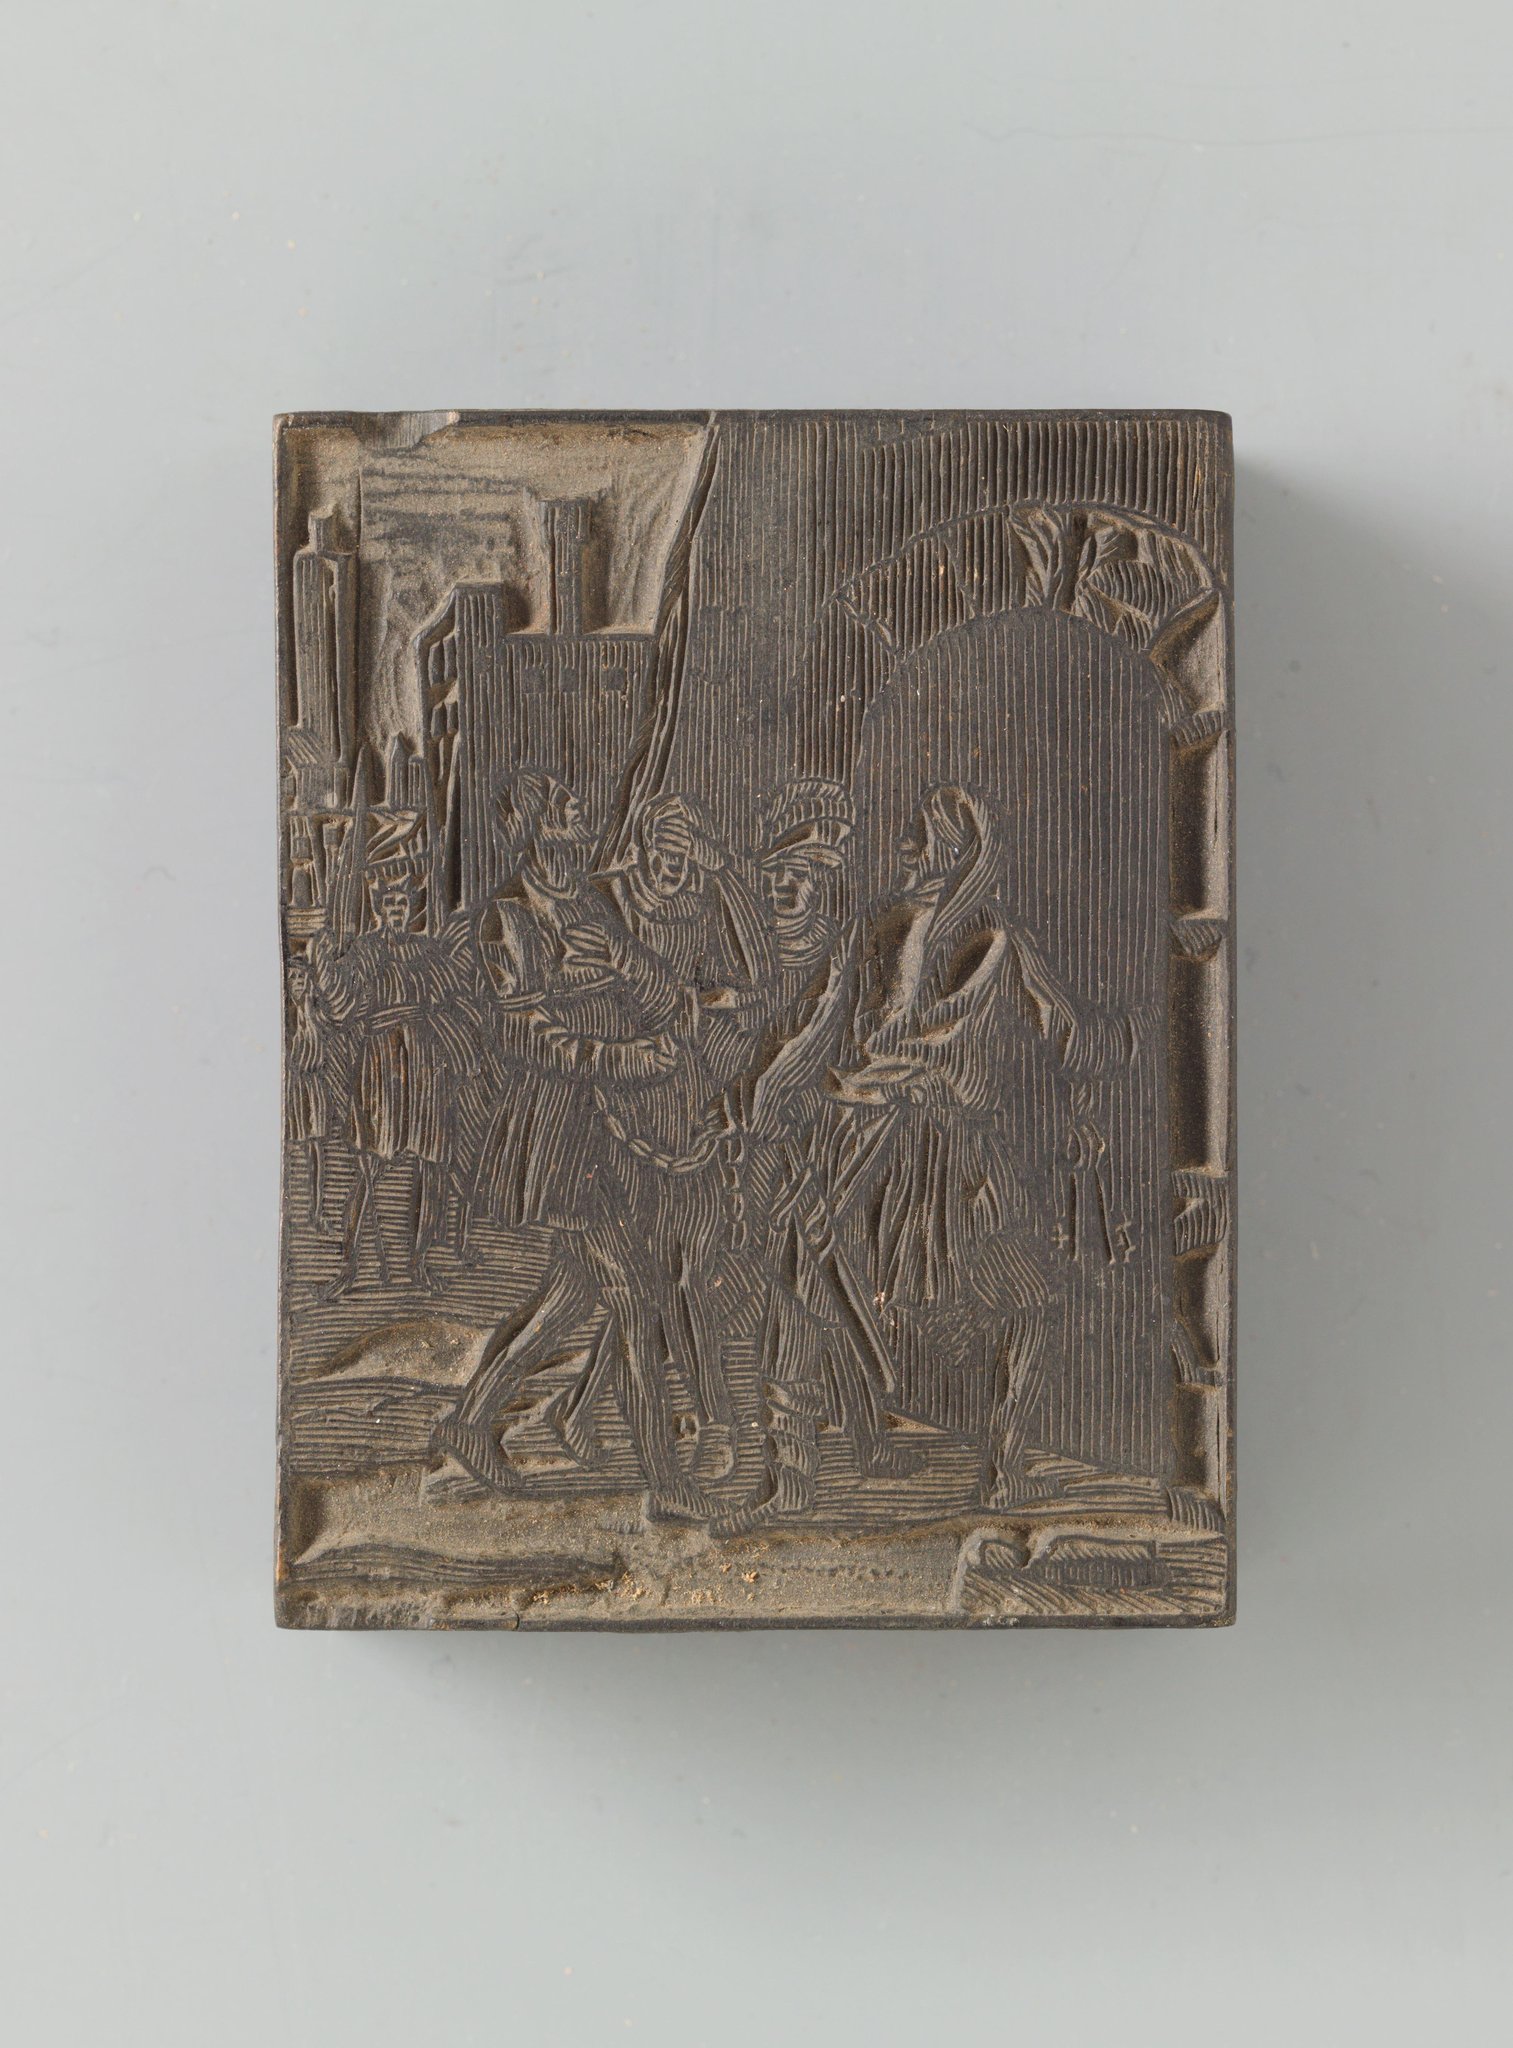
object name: wood block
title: Scénes: Mensen in middeleeuwse kleding voor een poort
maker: Anonymous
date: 1700-1899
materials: wood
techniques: woodcut